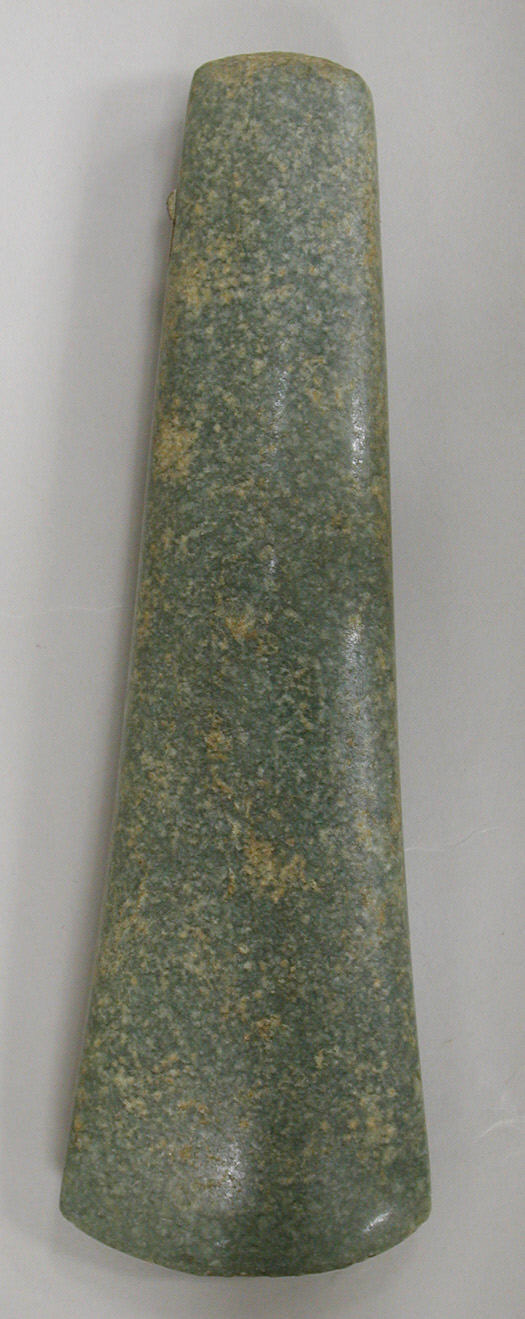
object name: celt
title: Stone Celt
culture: mexican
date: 1501-1600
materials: stone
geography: mexico